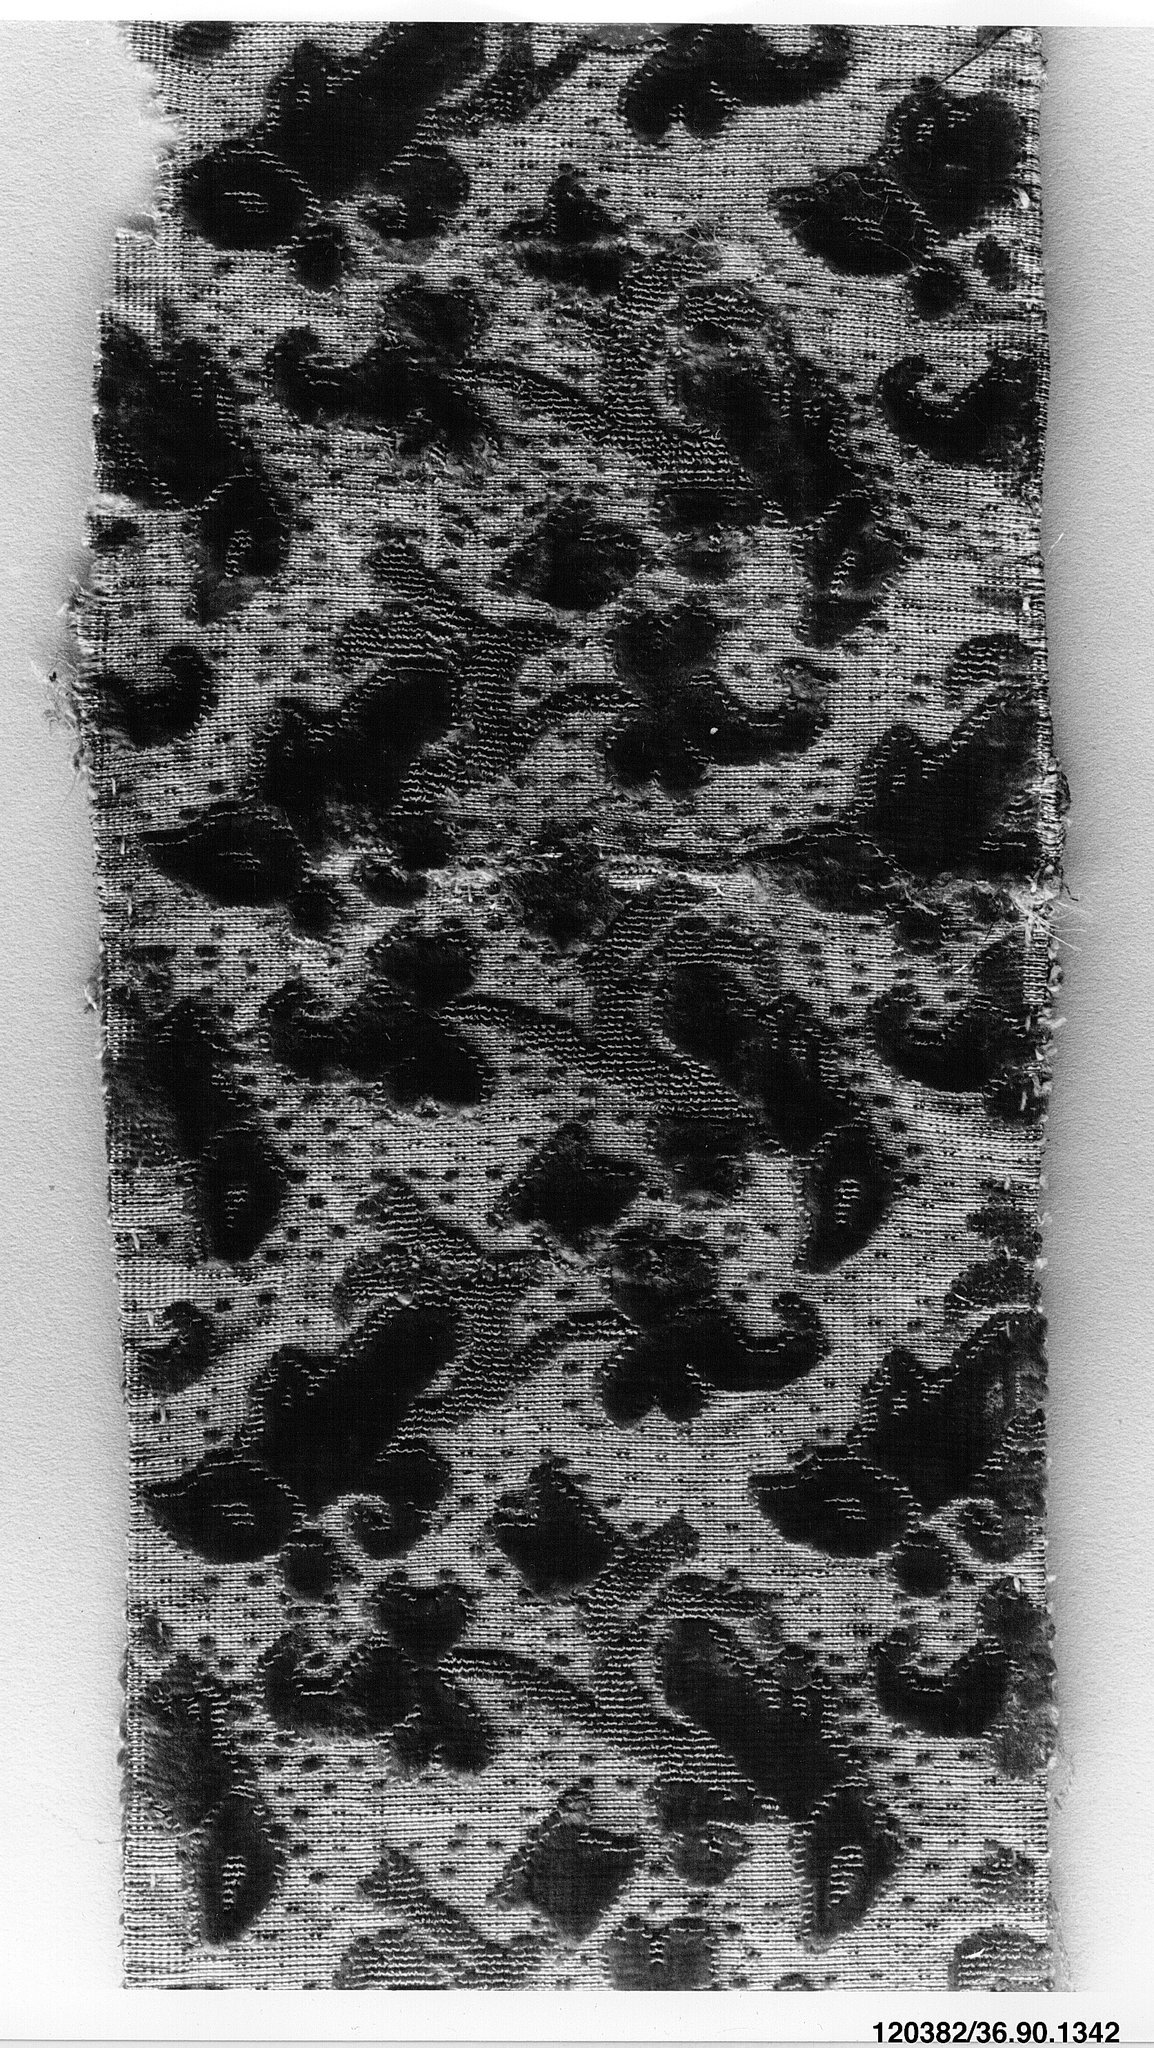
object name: piece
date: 1501-1700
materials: metal thread, silk